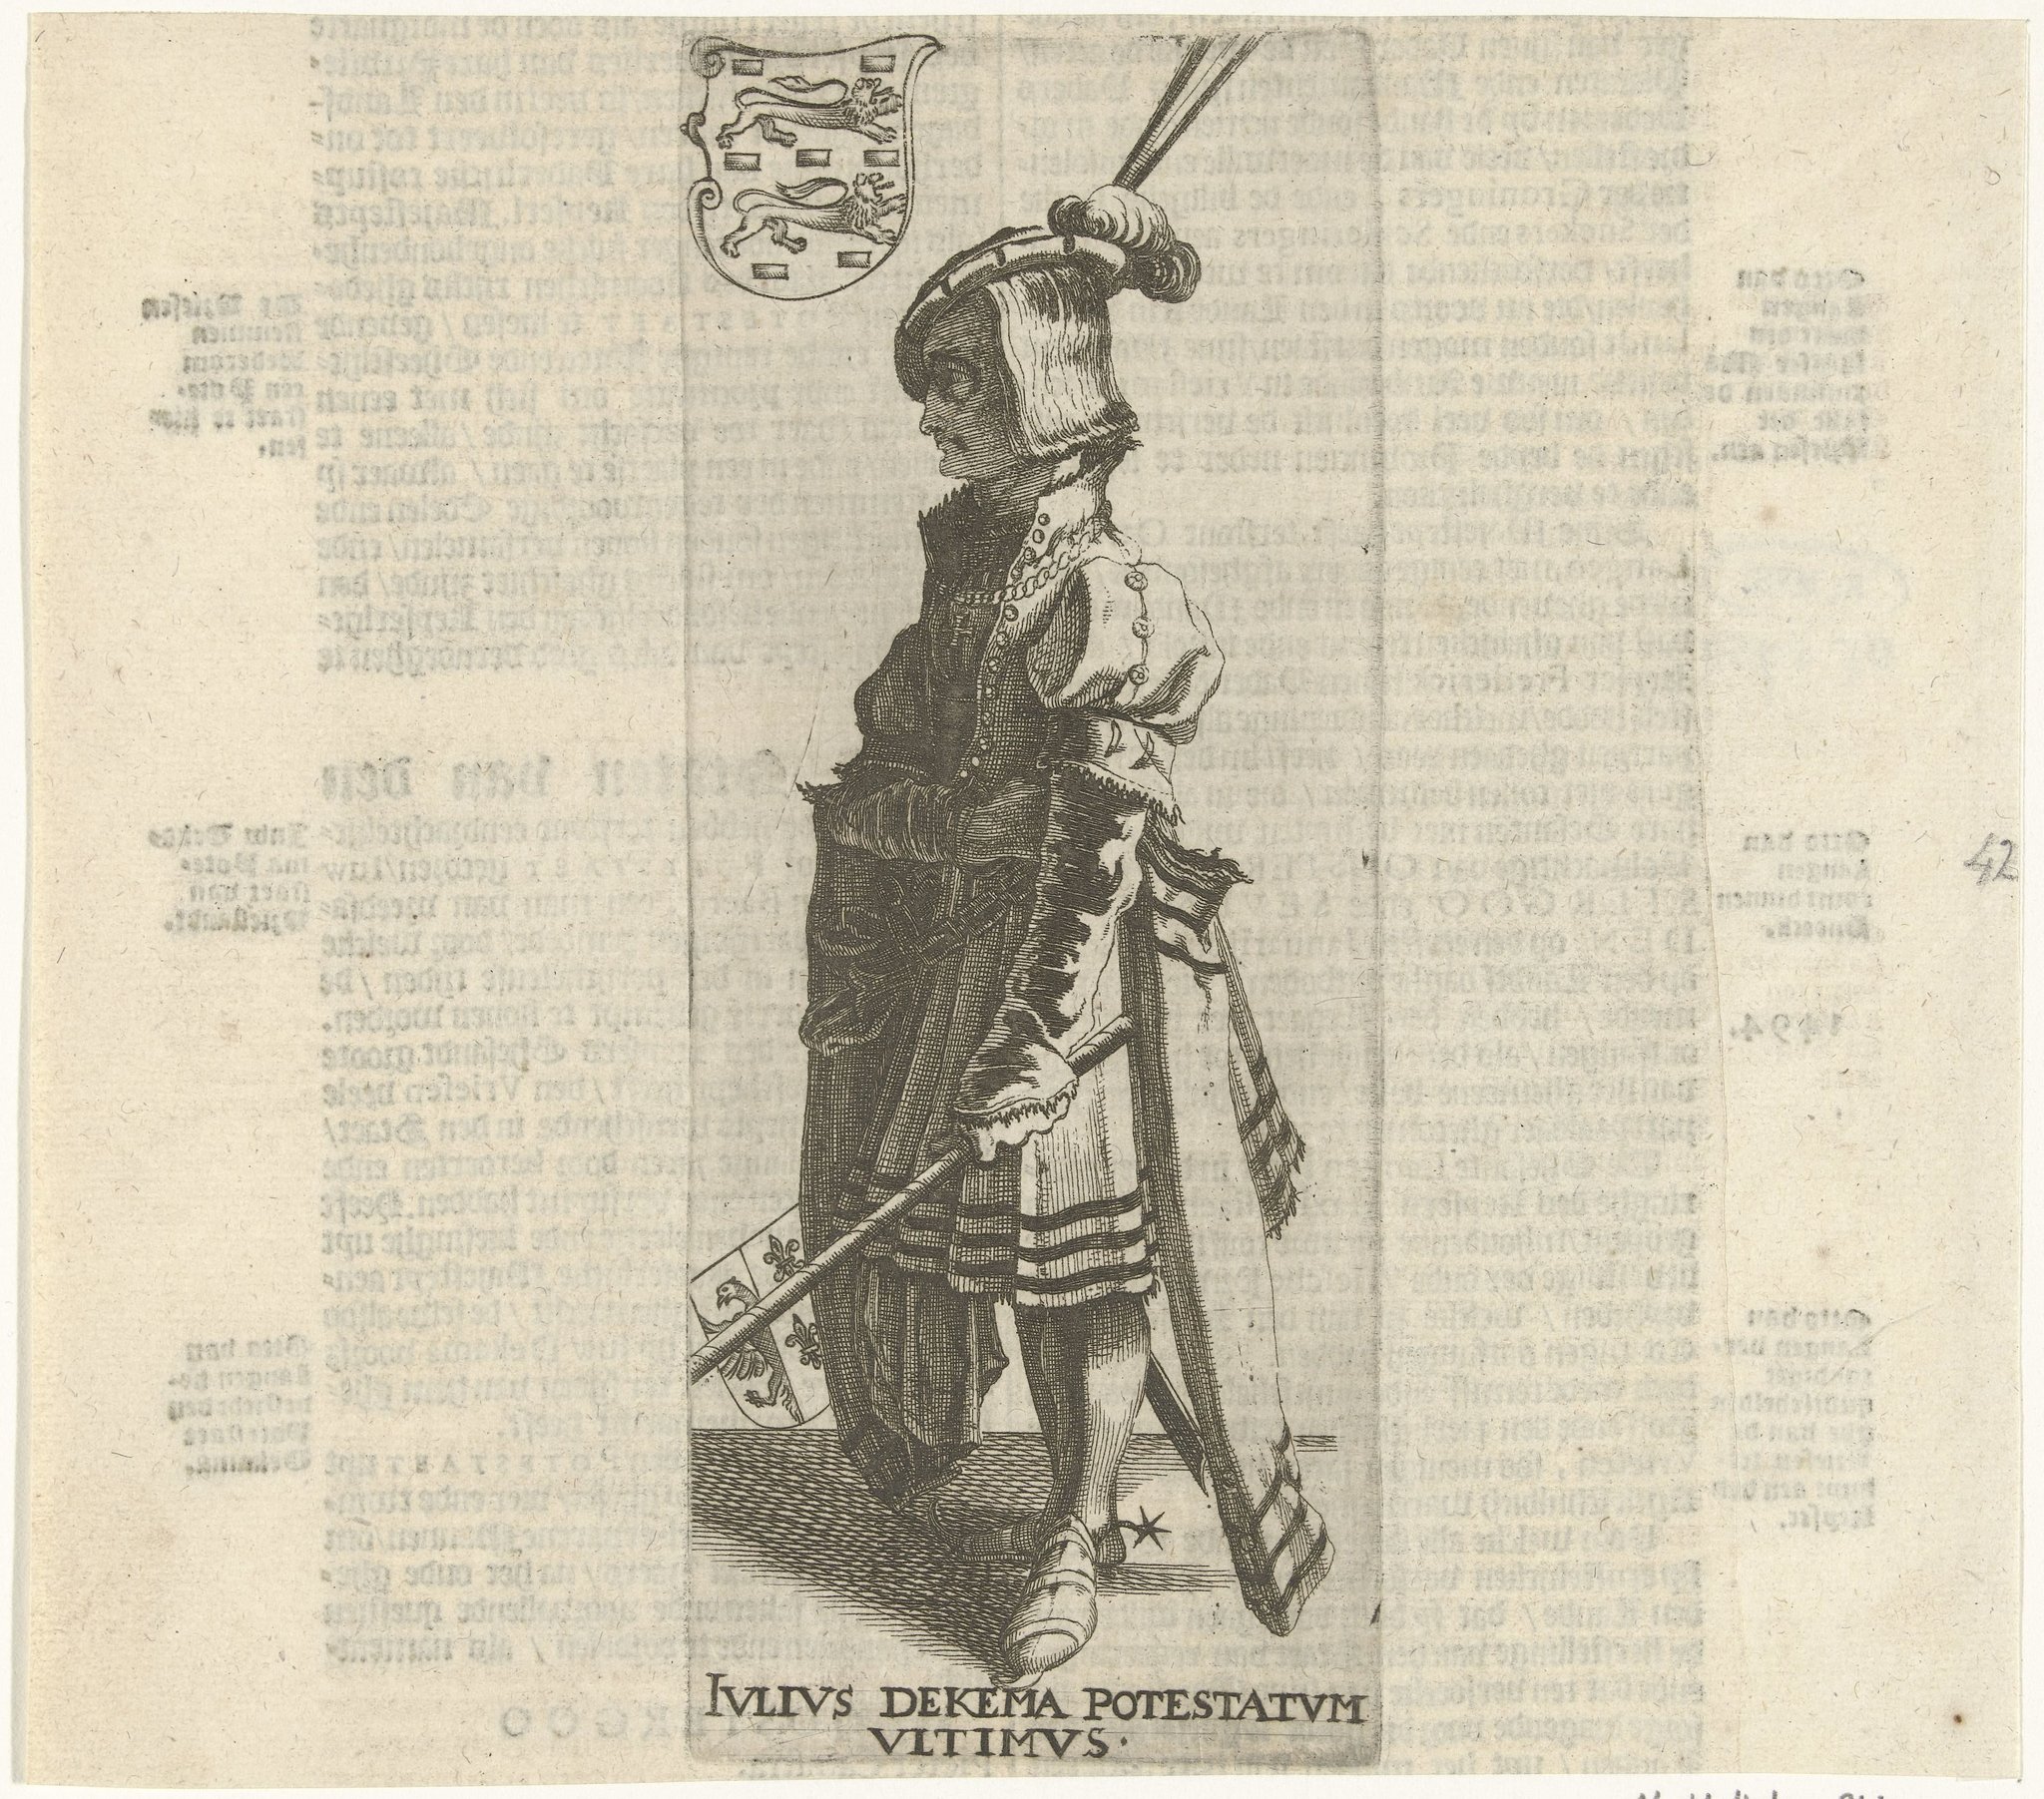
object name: print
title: De Friese vorsten, hertogen, koningen en hoofdelingen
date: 1622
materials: paper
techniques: etching, letterpress printing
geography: franeker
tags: juw dekama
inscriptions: collector's mark: Lugt 2228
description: De prent is ook als boekillustratie gebruikt in: Winsemius, P.W. Chronique ofte Historische geschiedenisse van Vrieslant (...). Franeker: Joannes Lamrinck, 1622.